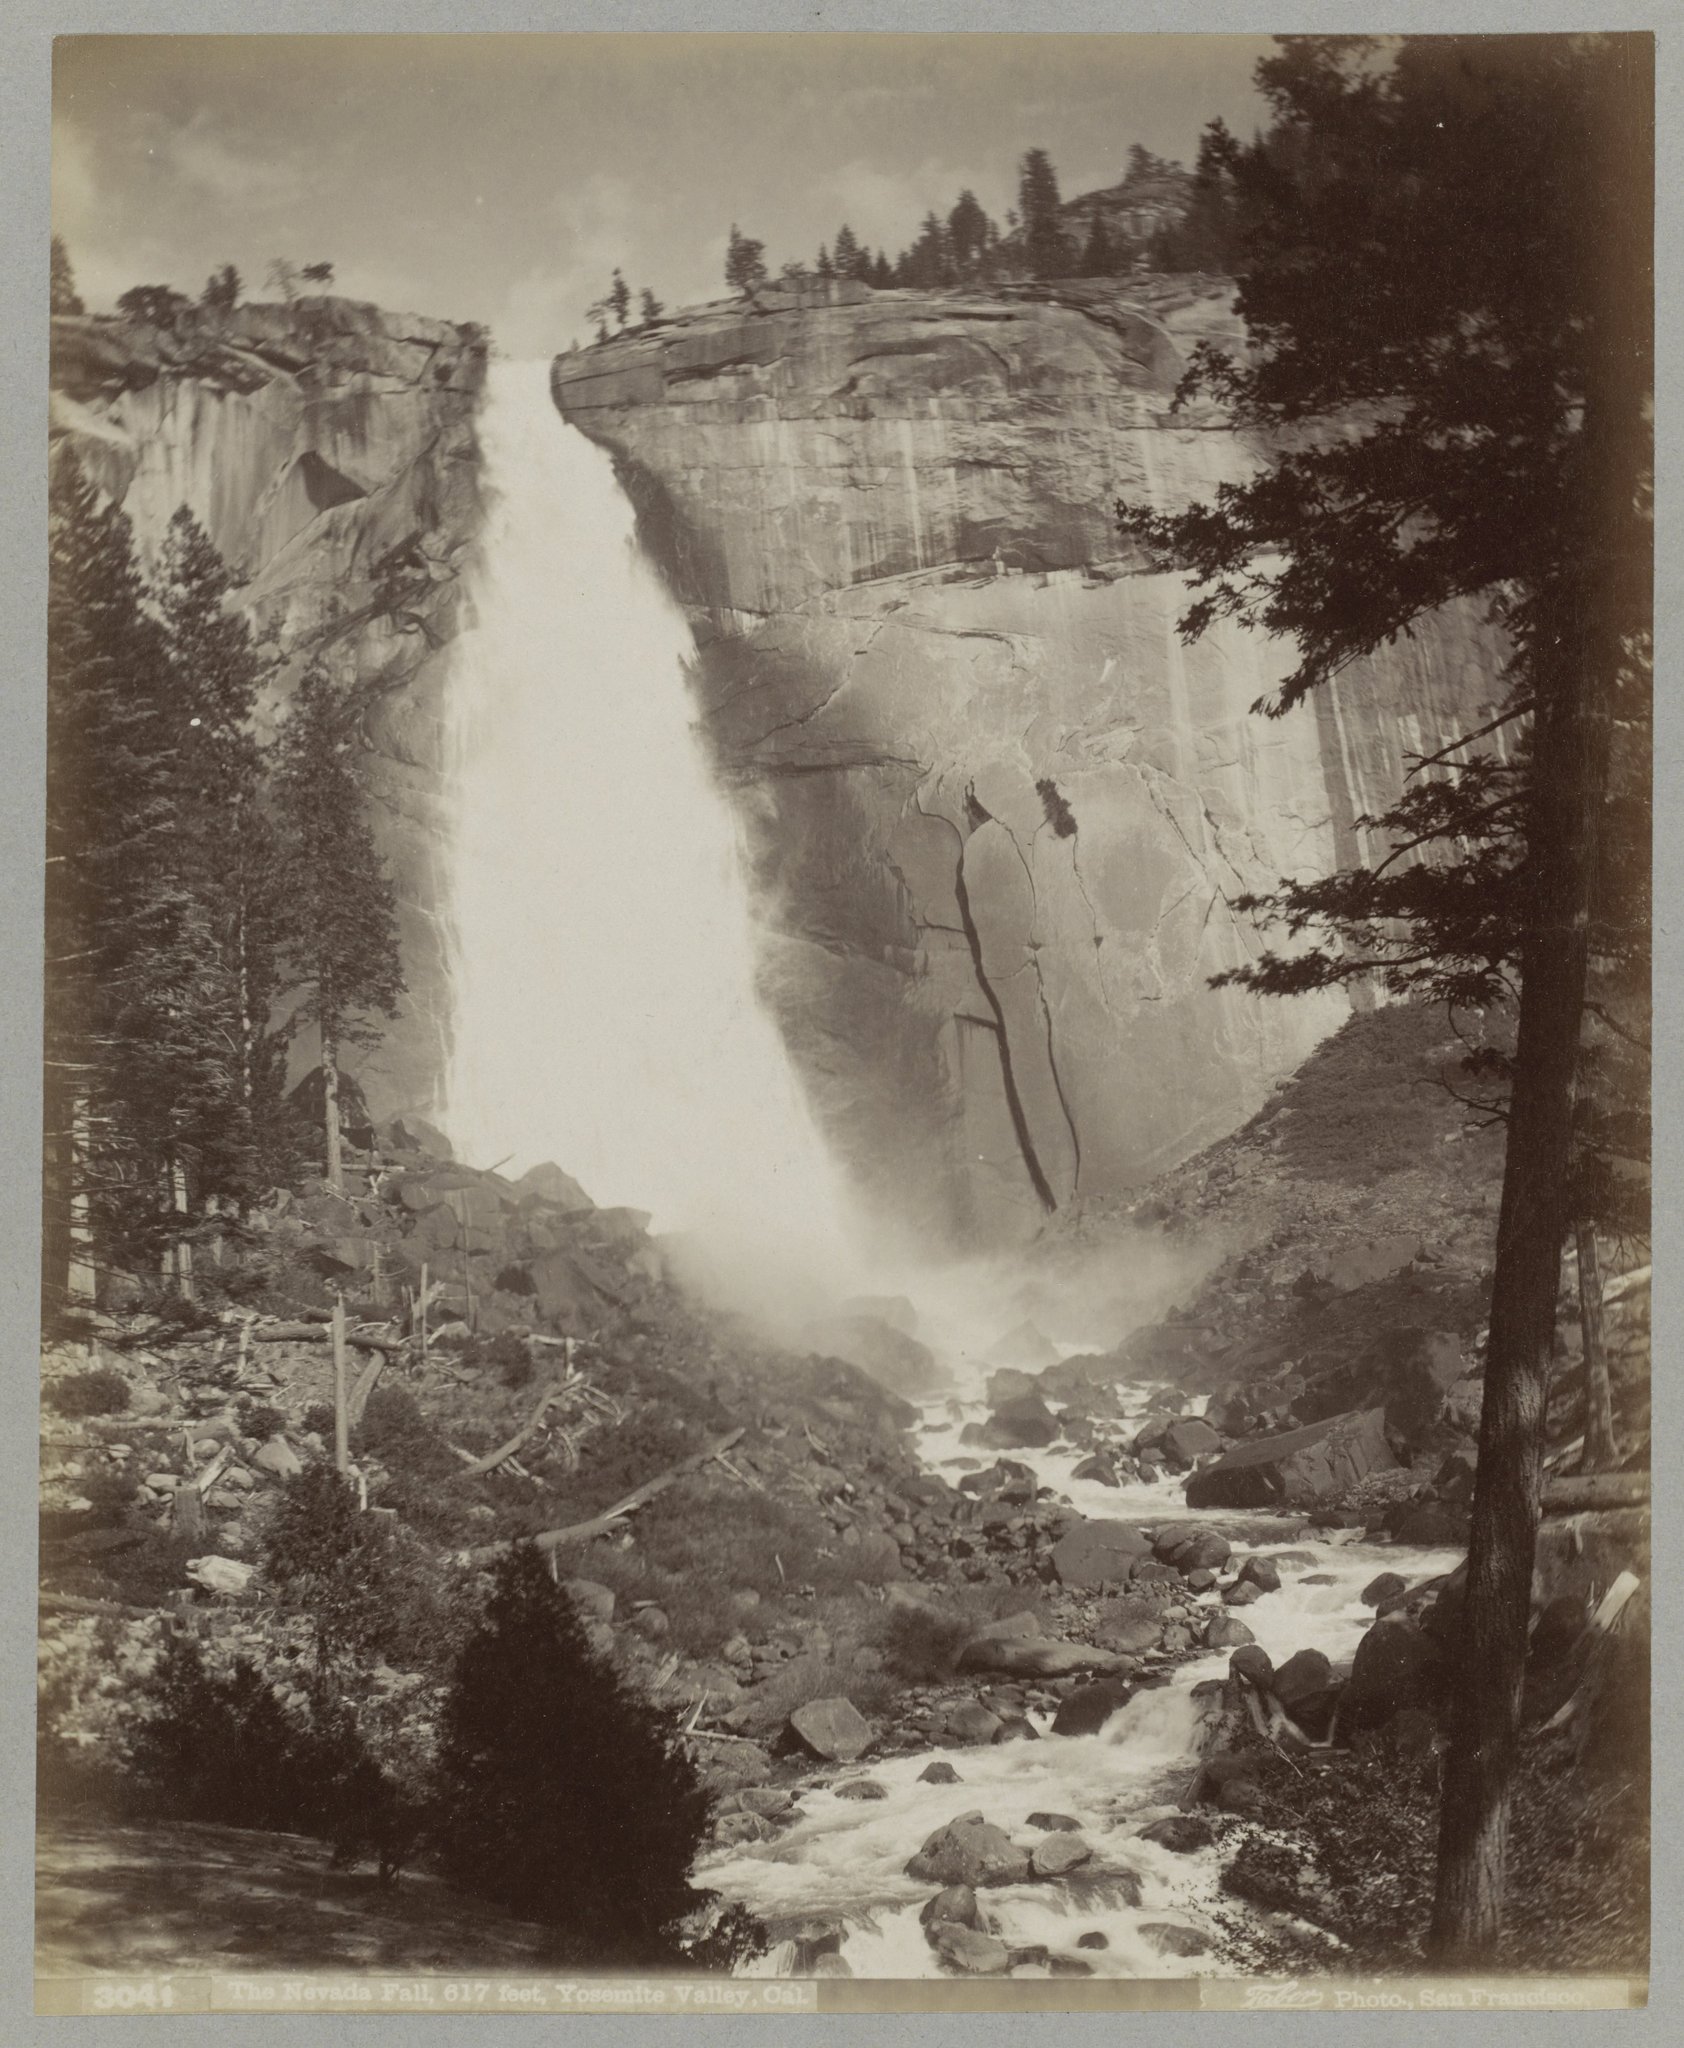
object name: photograph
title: Gezicht op de Nevada-waterval in Yosemite Valley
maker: isaiah west taber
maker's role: fotograaf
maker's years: 1830-1912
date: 1880-1900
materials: cardboard, paper, photographic support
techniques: albumen print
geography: yosemite valley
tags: waterfall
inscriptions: negative number: ‘3041’